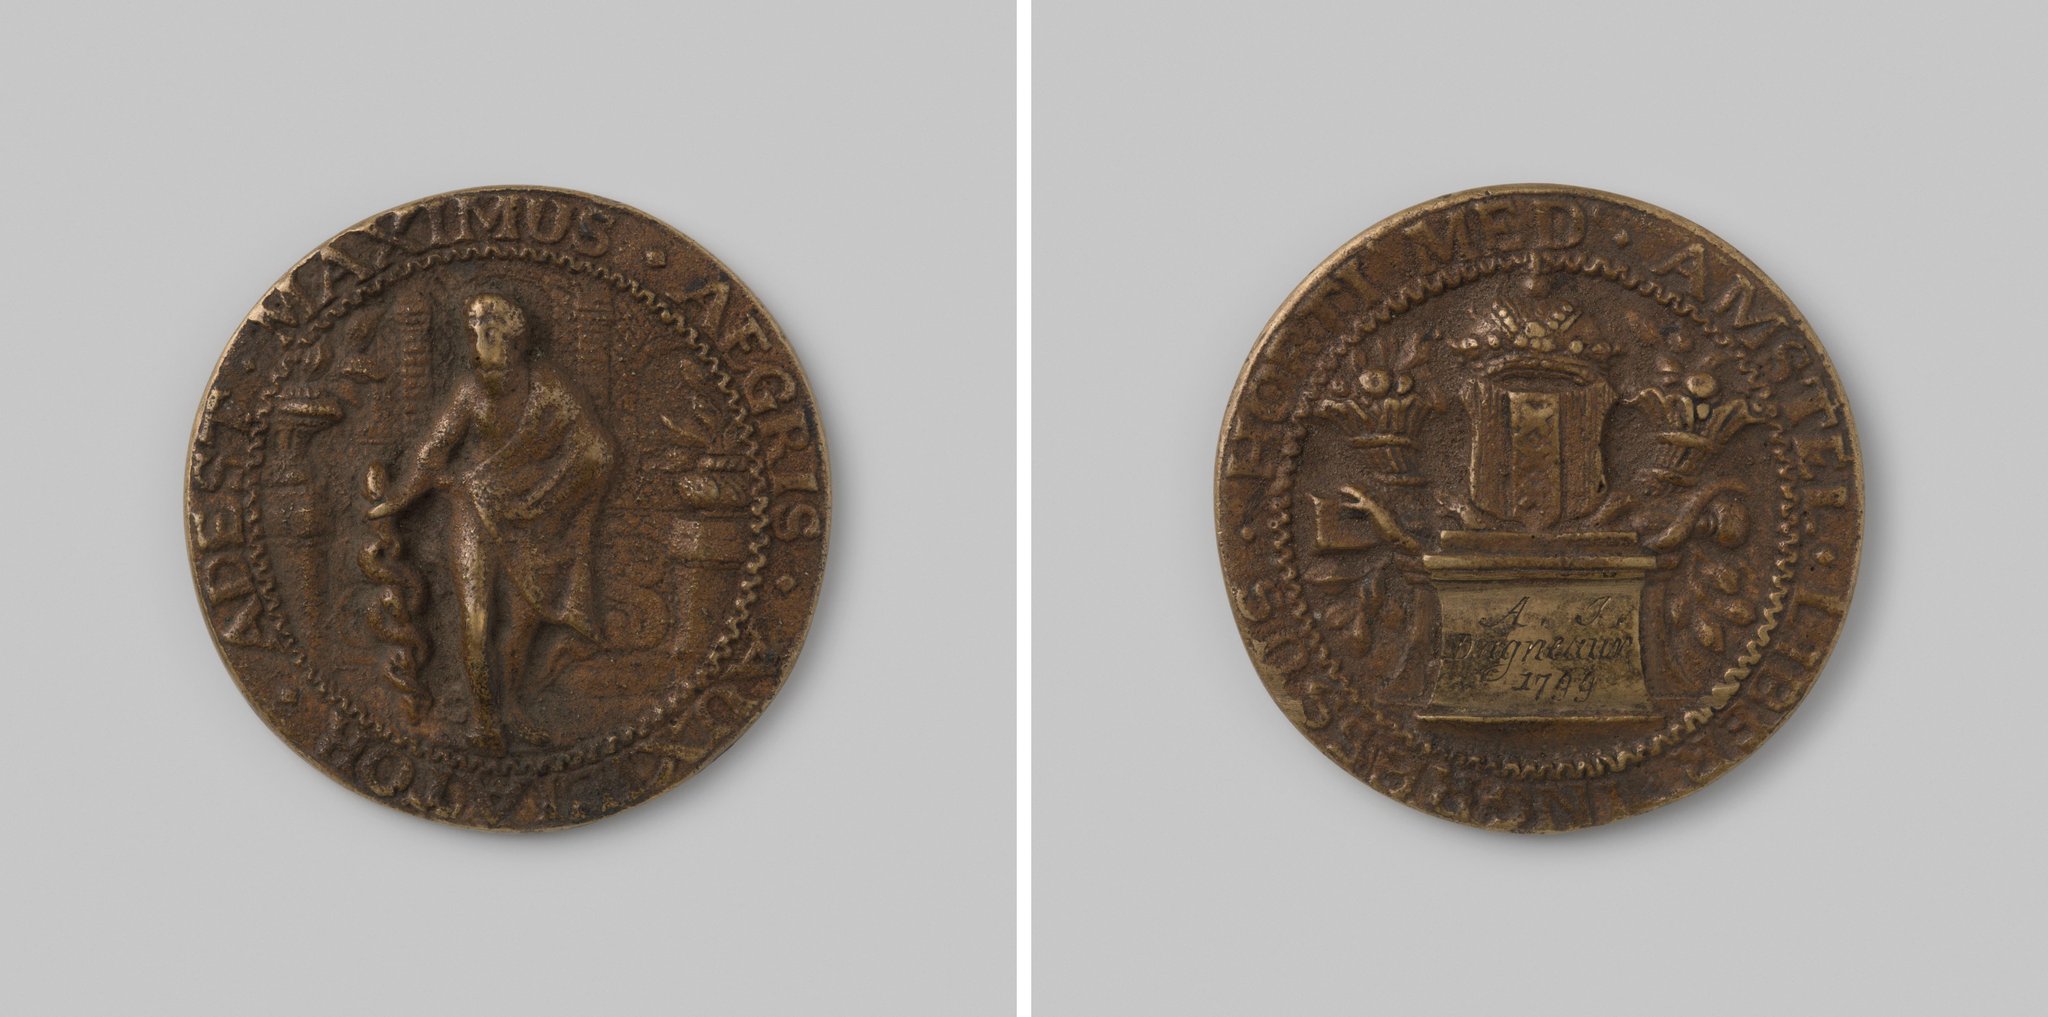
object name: history medal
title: Toegangspenning tot de Hortus Medicus te Amsterdam 1696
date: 1696-1699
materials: brass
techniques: casting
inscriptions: inscription: ‘A.J. / Dagneaux / 1799’, circumscription: ‘HORTI MED AMSTEL LIBER INGRESSUS’, circumscription: ‘MAXIMUS AEGRIS AUXILIATOR ADEST’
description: Gegoten messing penning met op de voorzijde Aesculapius en op de keerzijde een altaar waarop het gekroonde stadswapen, een caduceus en cornucopiae waaruit kruidentakken, op naam van A.J. Dagneaux 1799